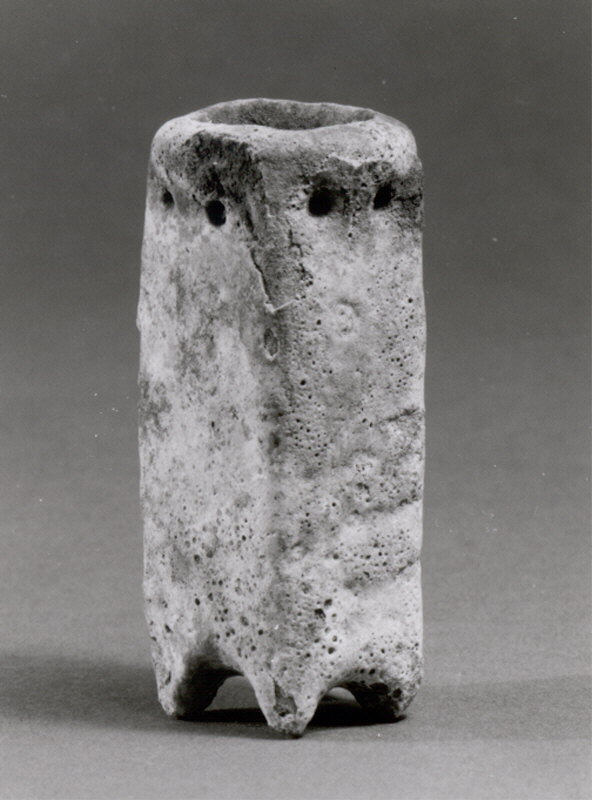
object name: cosmetic container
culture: iranian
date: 900-801 BCE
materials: faience, glaze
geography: iran